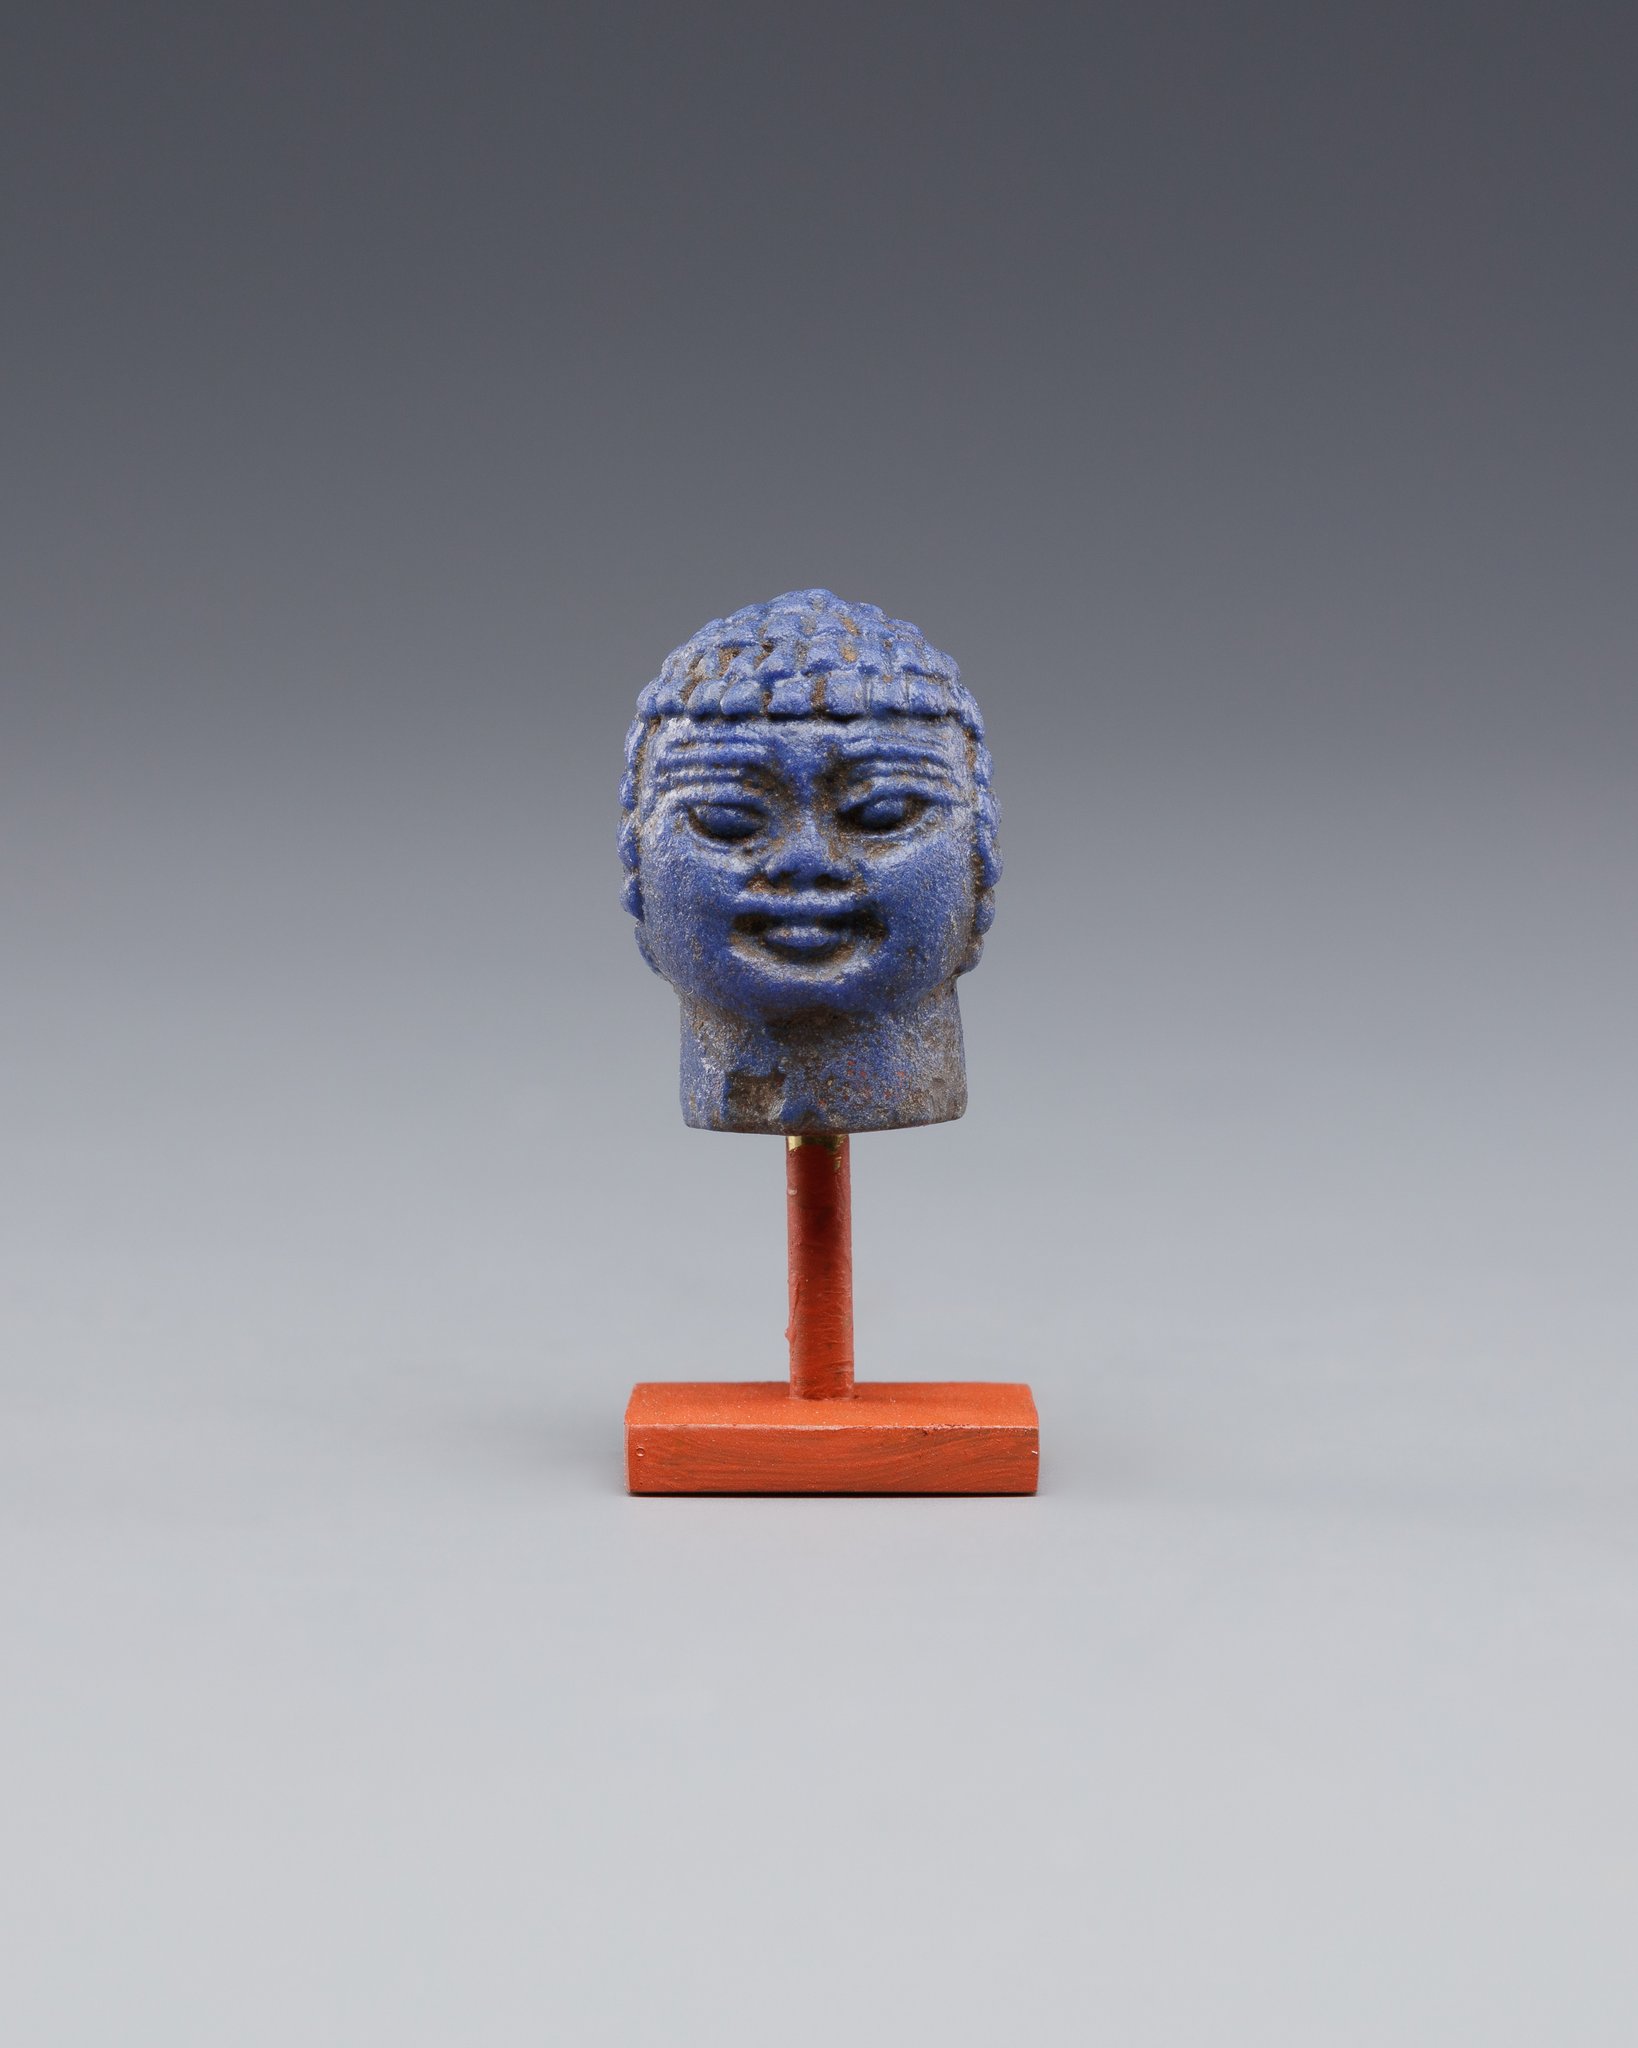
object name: head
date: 101-200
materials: glass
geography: egypt and sudan